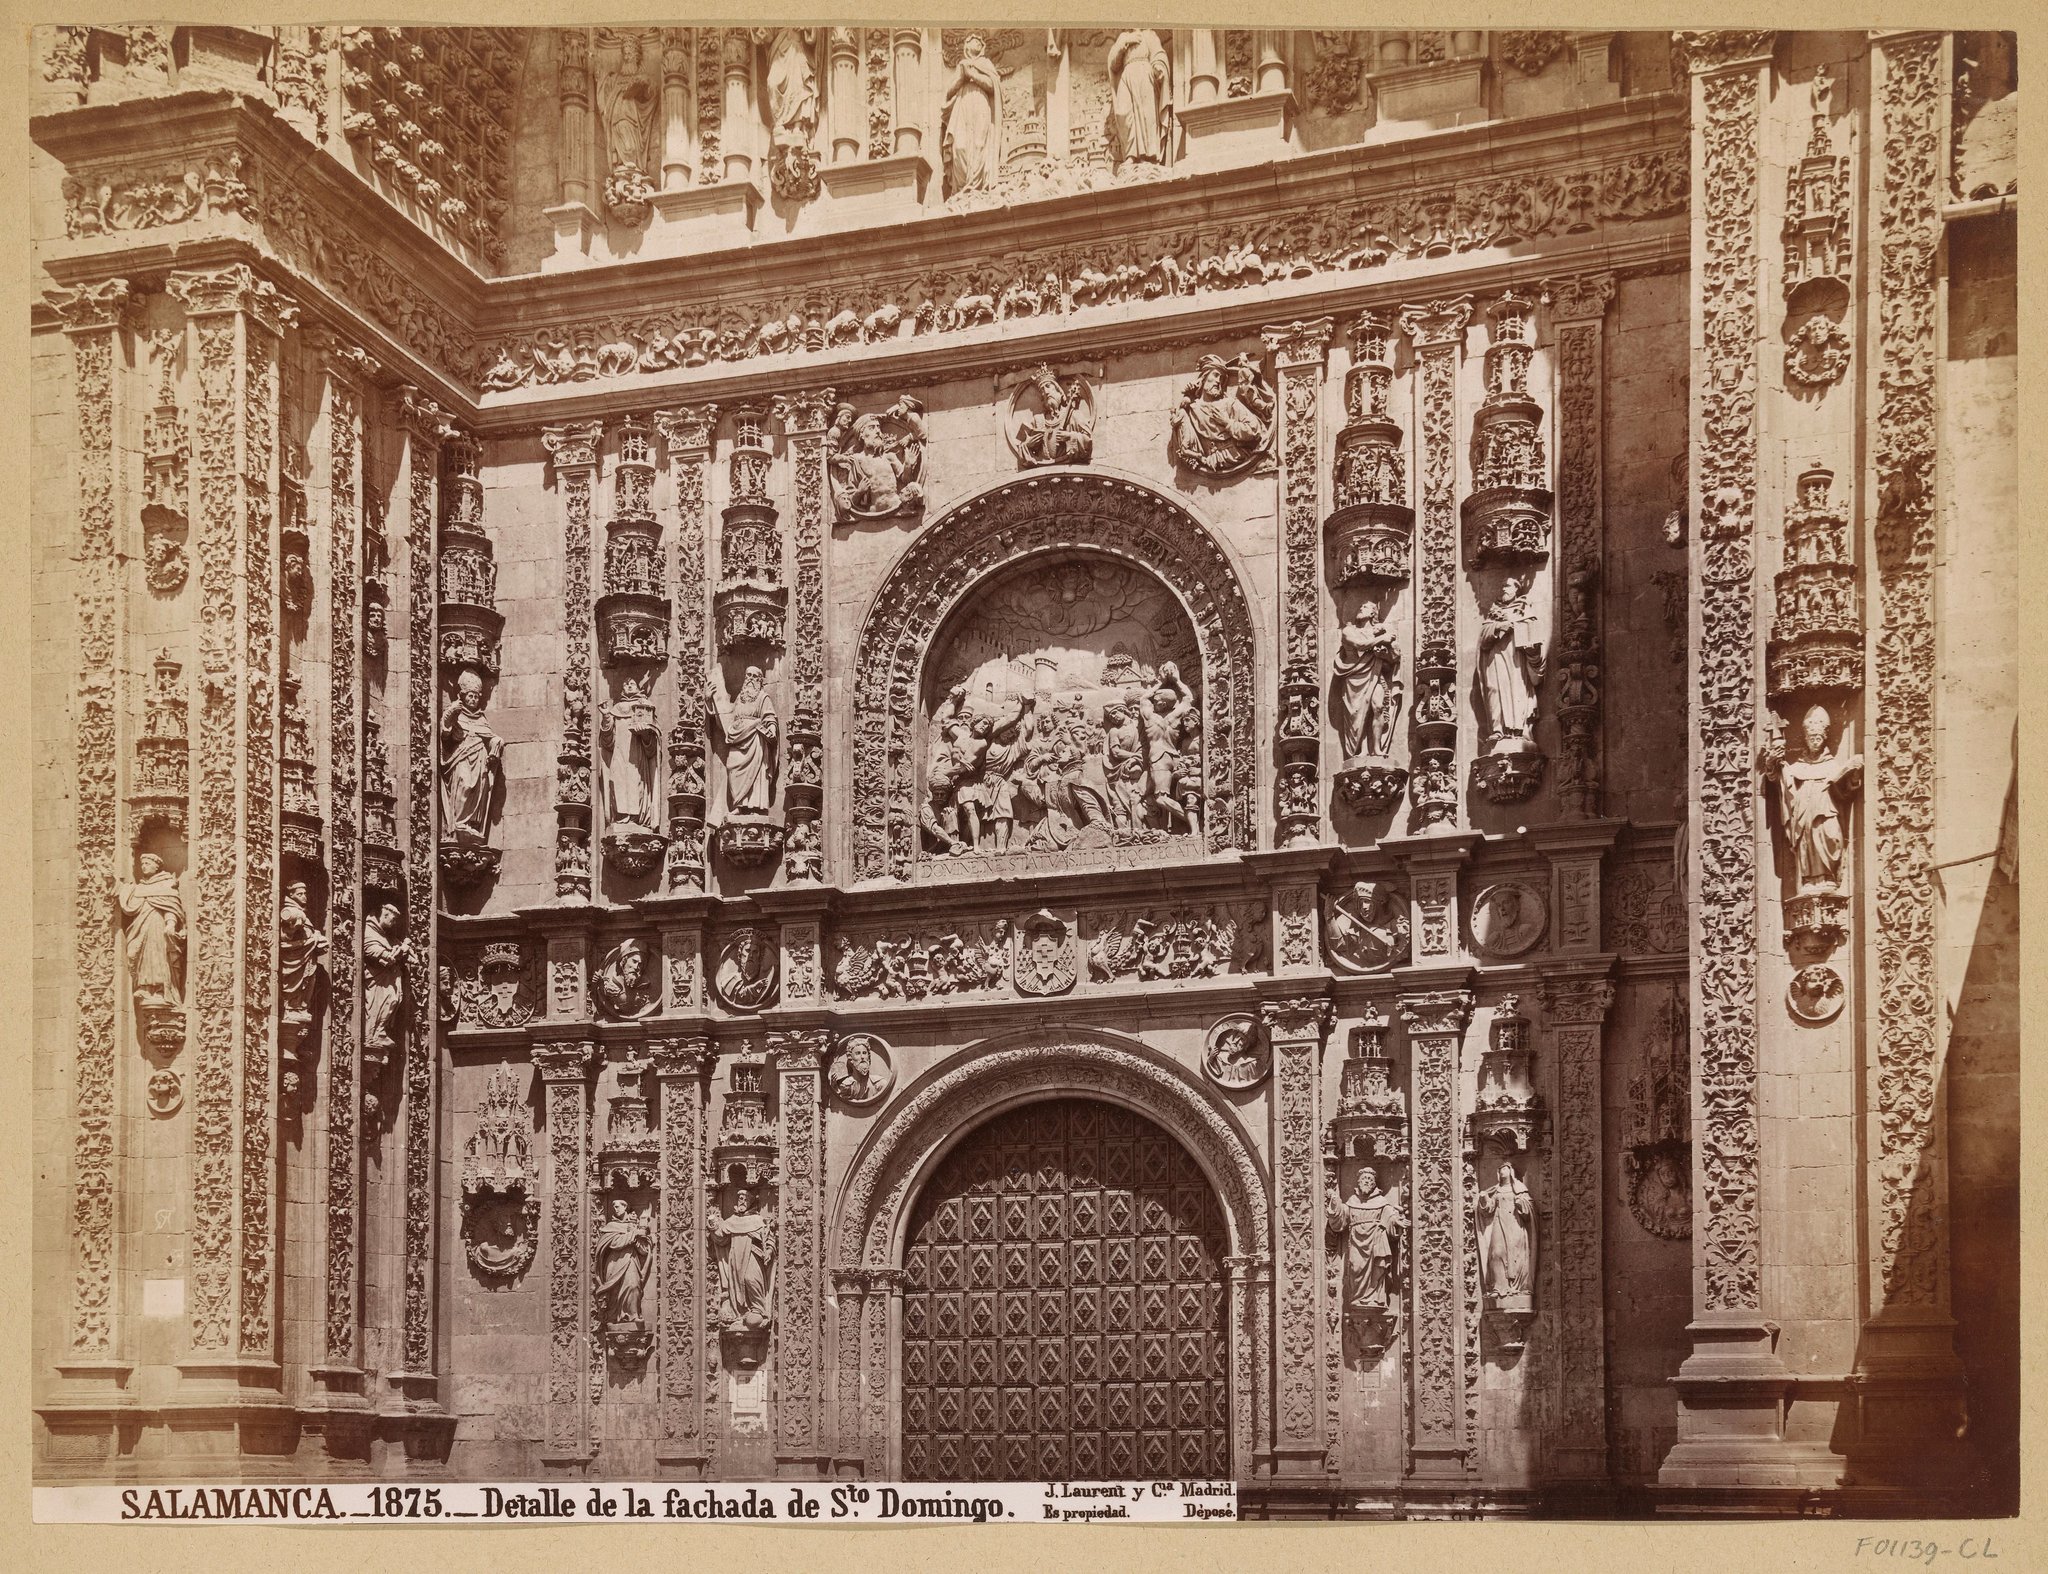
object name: album leaf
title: Façade van de Convento de San Esteban in Salamanca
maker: juan laurent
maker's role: publisher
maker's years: 1816-1896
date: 1863-1883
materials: paper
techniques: albumen print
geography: salamanca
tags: parts of church exterior and annexes: portal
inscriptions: number: ‘1875’, inscription: ‘Es propiedad./ Déposé.’